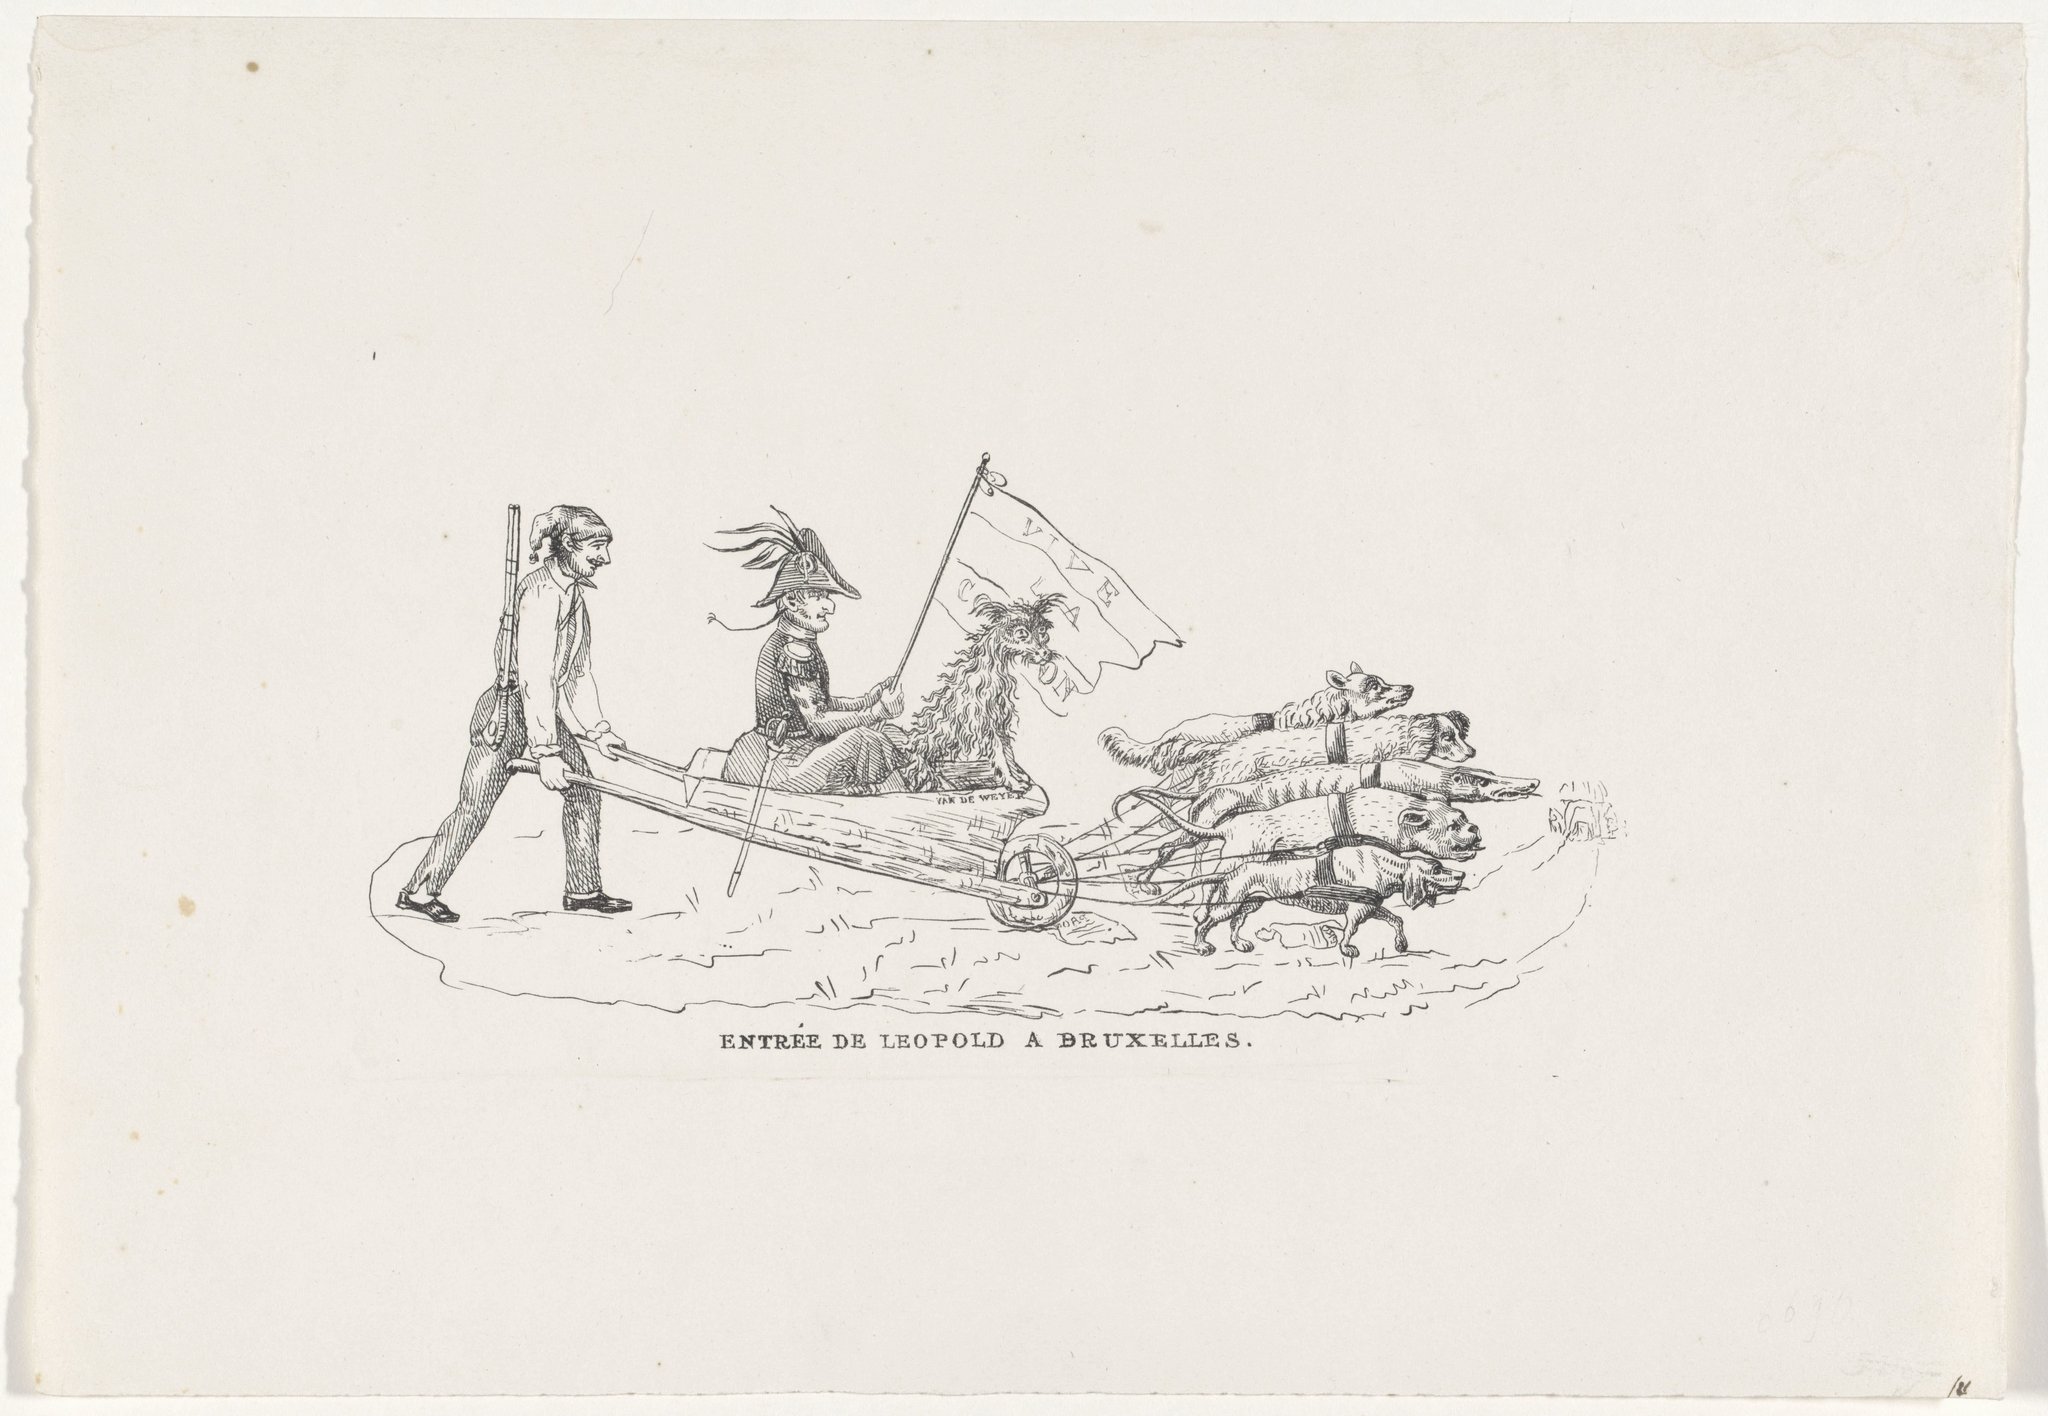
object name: print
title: Entrée de Léopold a Bruxelles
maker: Anonymous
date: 1831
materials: paper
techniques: lithograph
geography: belgium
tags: laeken, leopold i (koning der belgen), public festivities at other royal events, not meant or mentioned above, triumphal entry and public reception, pageant, 'entrée solennelle', 'joyeuse entrée', wheelbarrow, brussels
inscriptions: collector's mark: Lugt 2228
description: Spotprent op de intocht van koning Leopold I in Brussel voor de inhuldiging op 21 juli 1831. De koning met zijn poedel (Sylvain van de Weyer) zittend in een kruiwagen voortgeduwd door een Belgische opstandeling en getrokken door vijf honden (de vijf grote mogendheden).